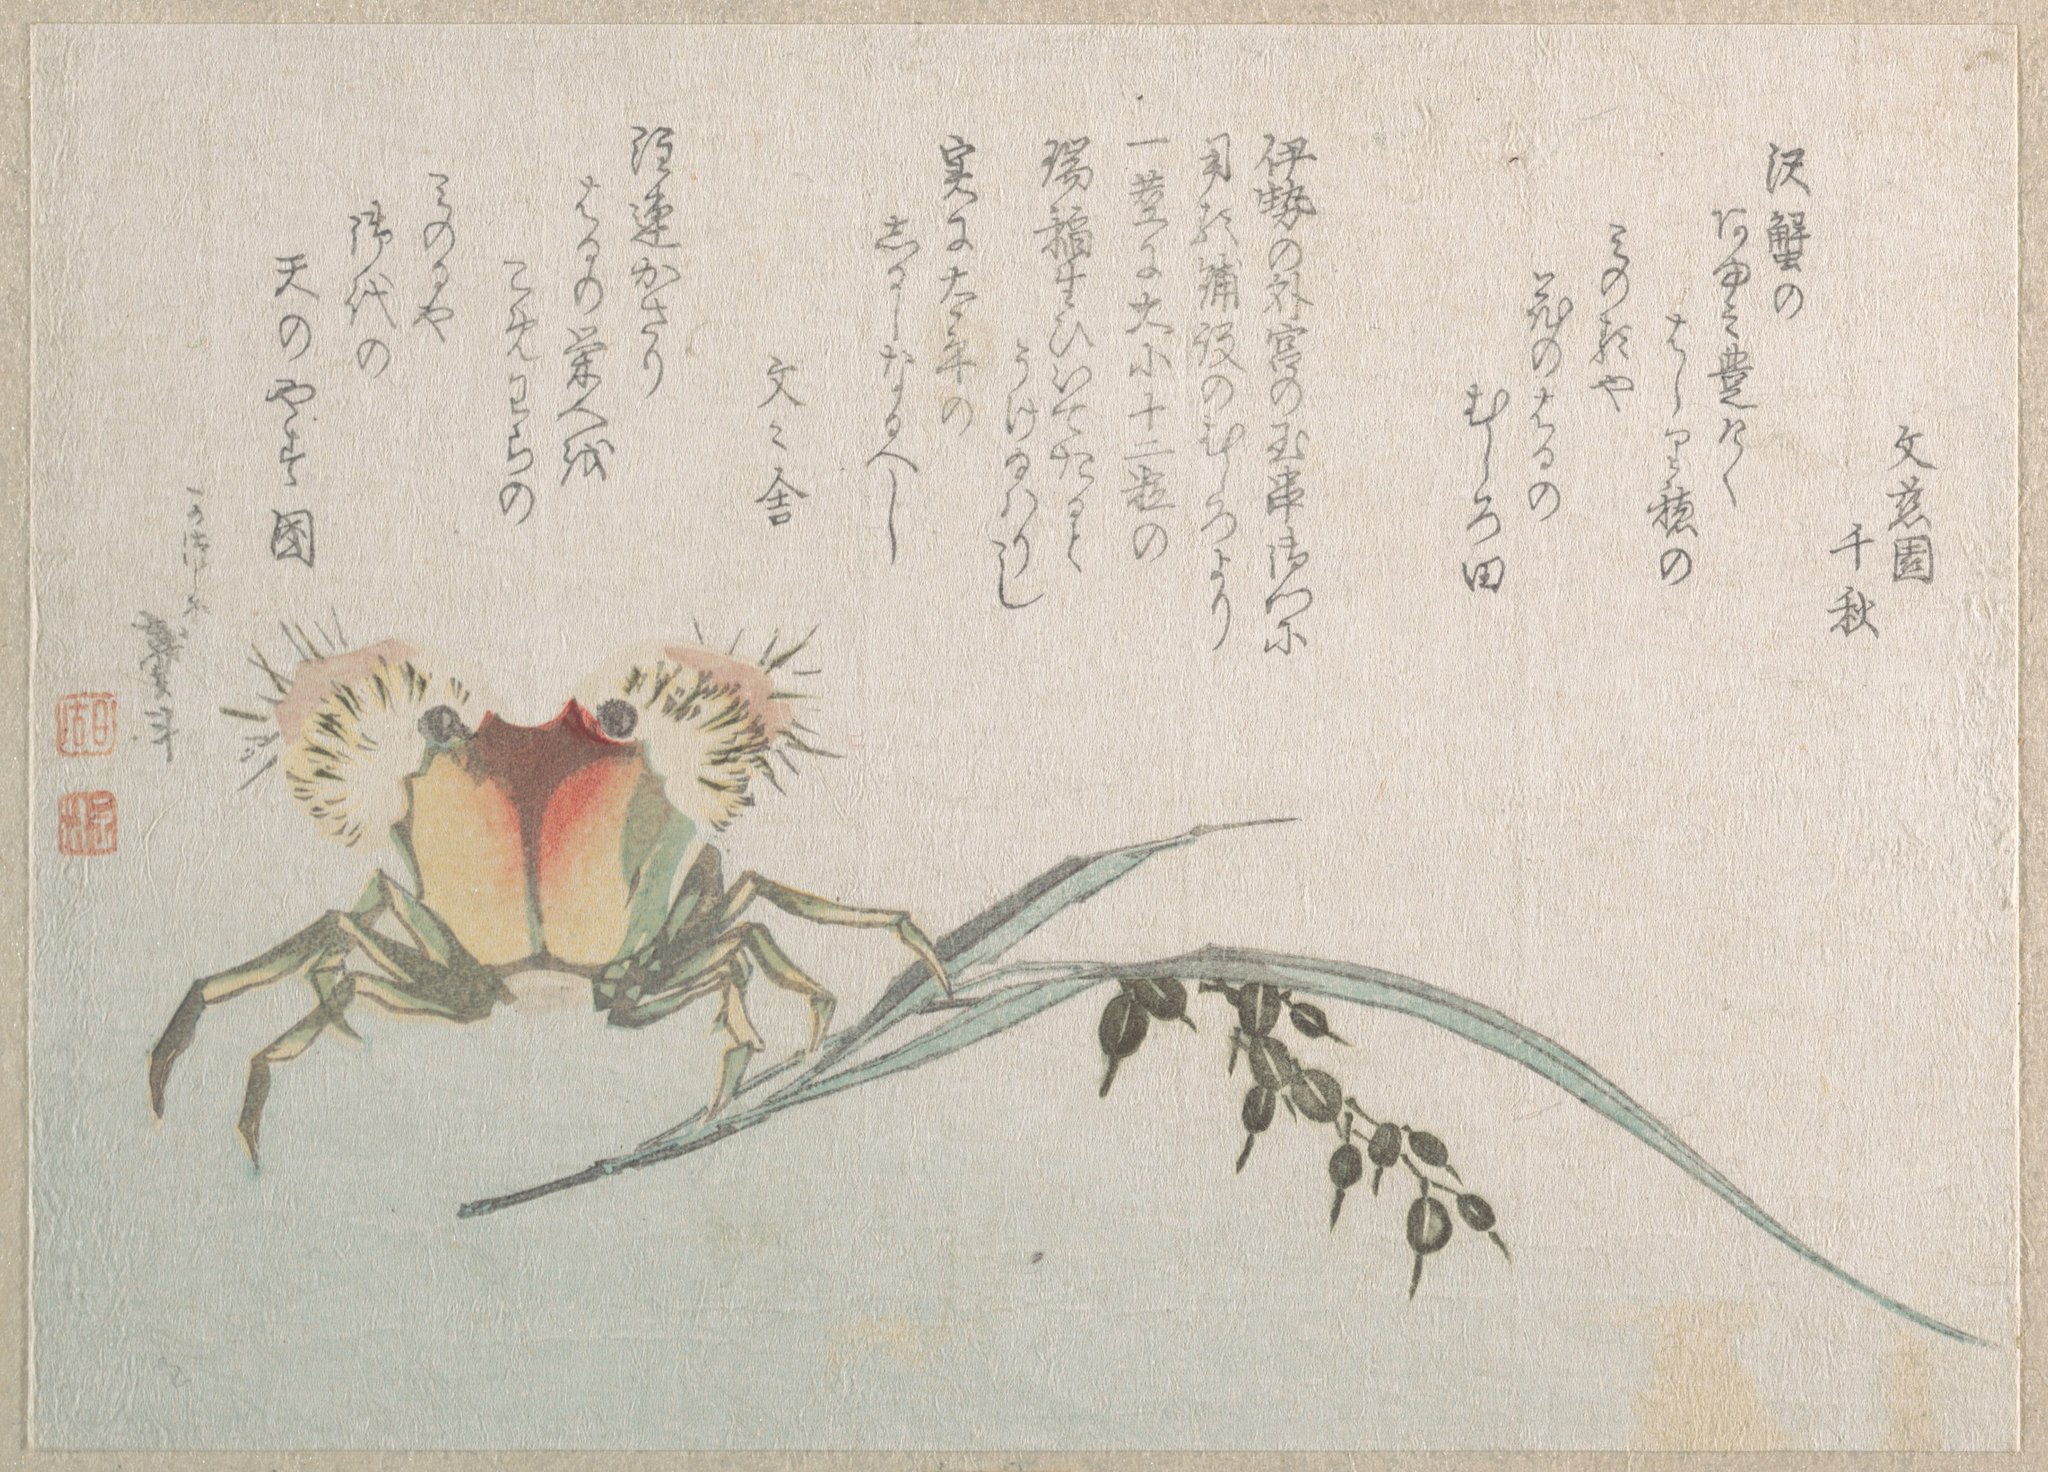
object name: print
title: Crab and Rice Plant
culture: japanese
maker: katsushika hokusai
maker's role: artist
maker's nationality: japanese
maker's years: 1760-1849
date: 1801-1900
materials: ink, paper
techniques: surimono, woodblock print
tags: crabs,plants